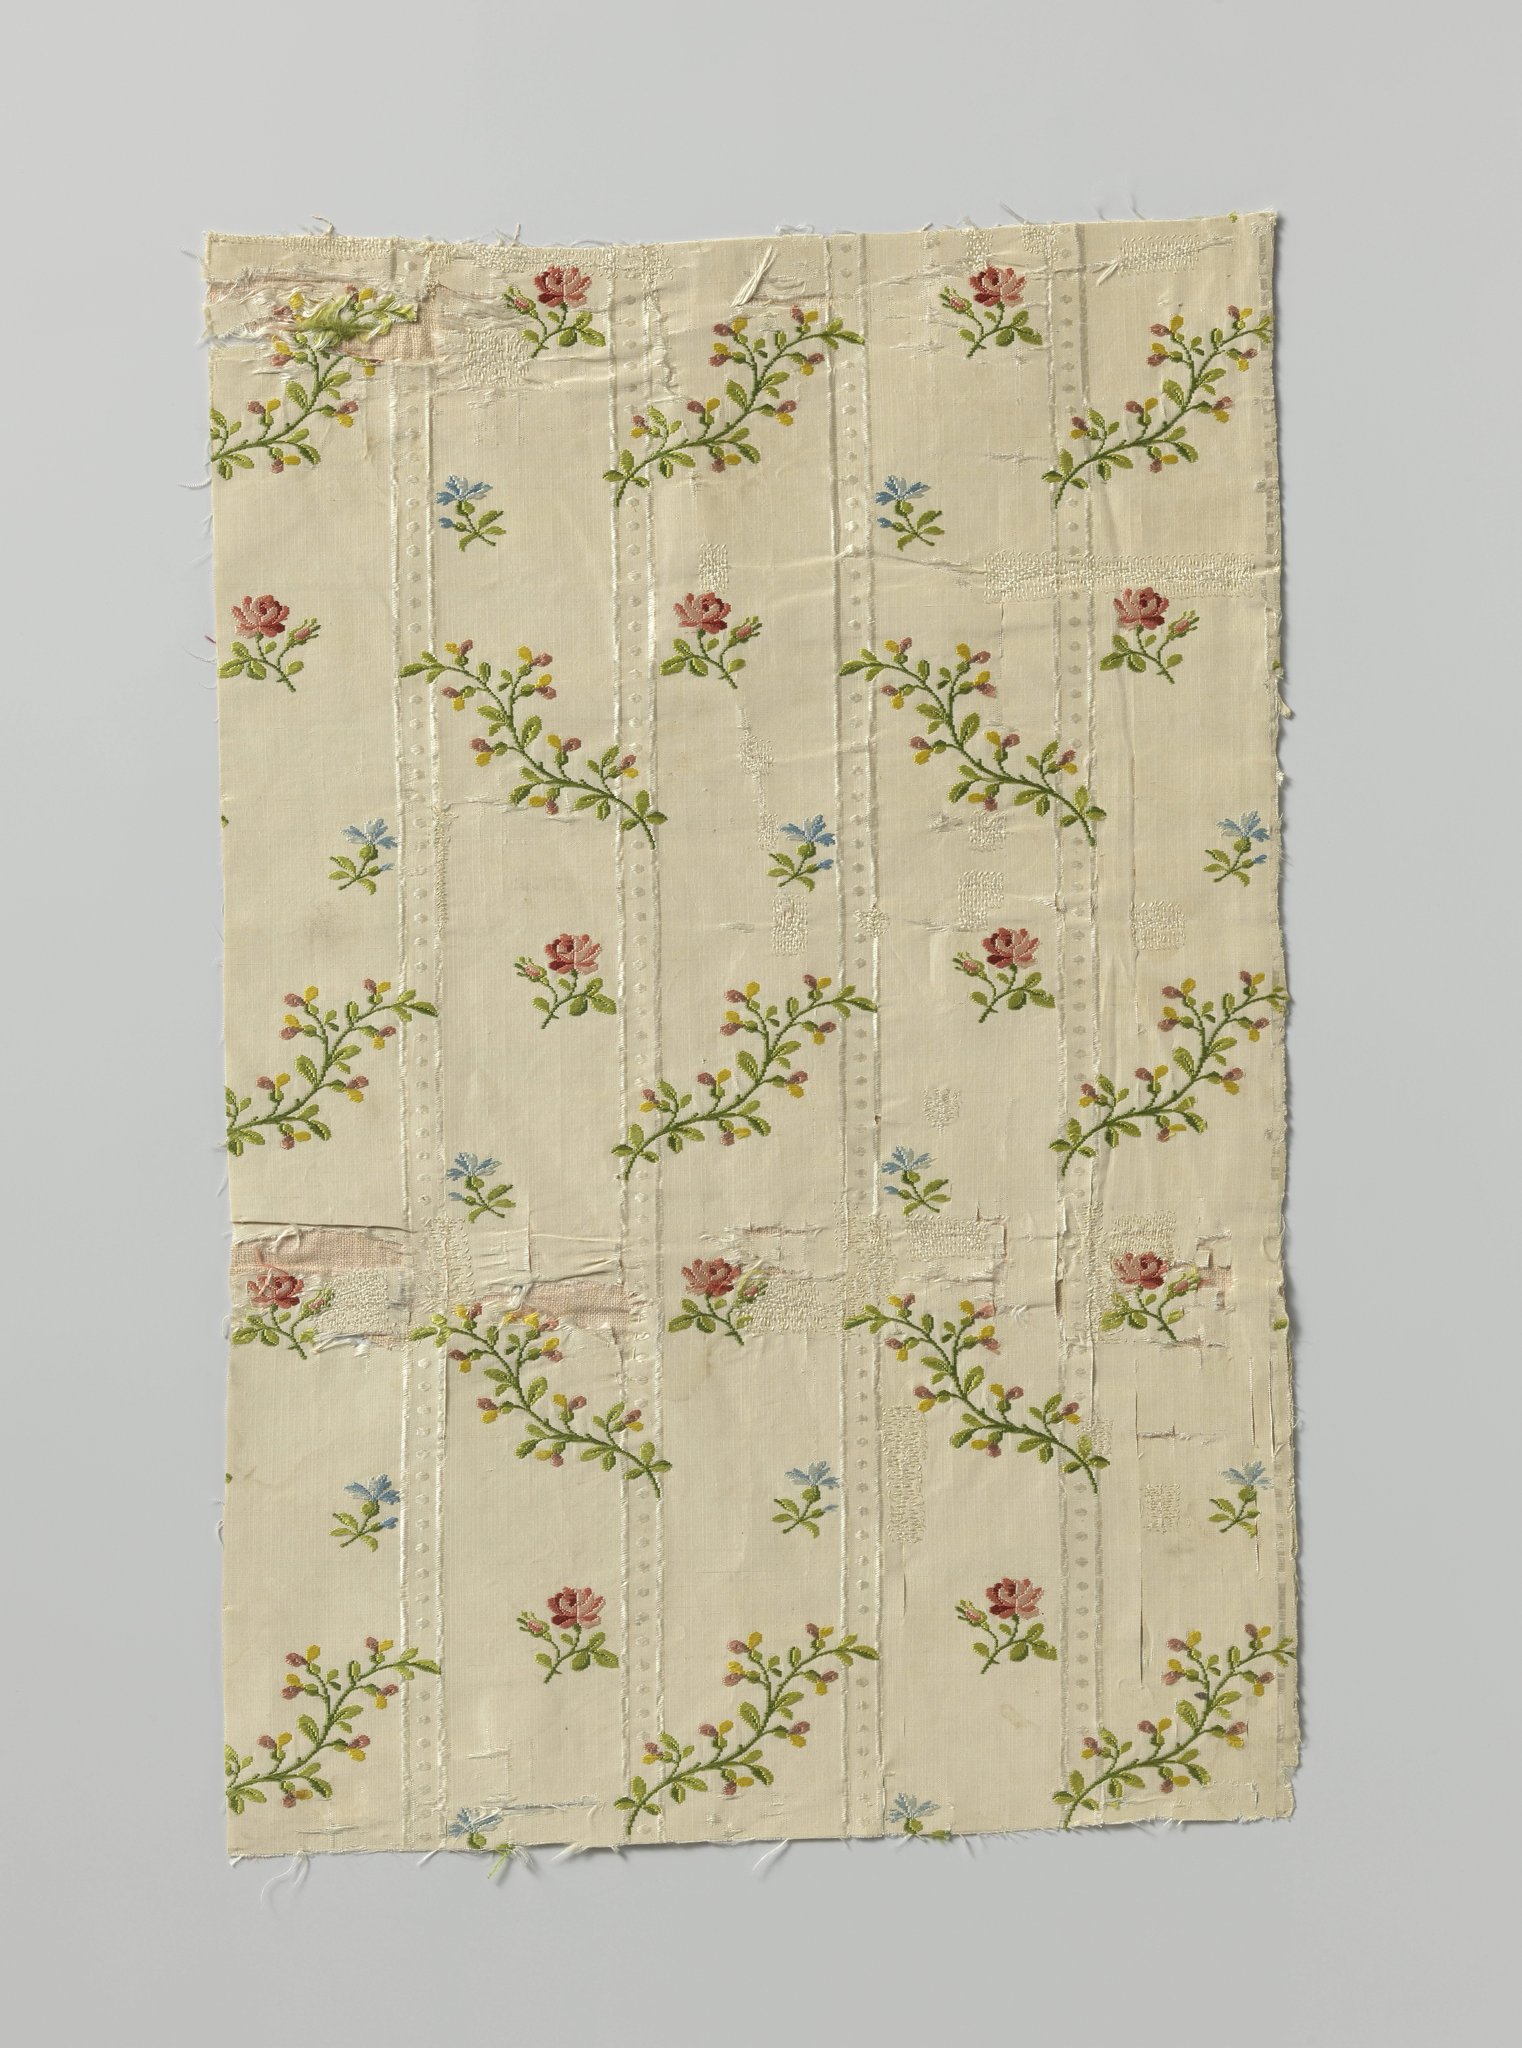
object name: fragment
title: Fragment veelkleurig gestreept zijden pekin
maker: Anonymous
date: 1750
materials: silk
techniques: brocade, weave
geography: spain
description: Een fragment van witte zijde met strepen, waarover veelkleurige gestrooide bloemtakken.